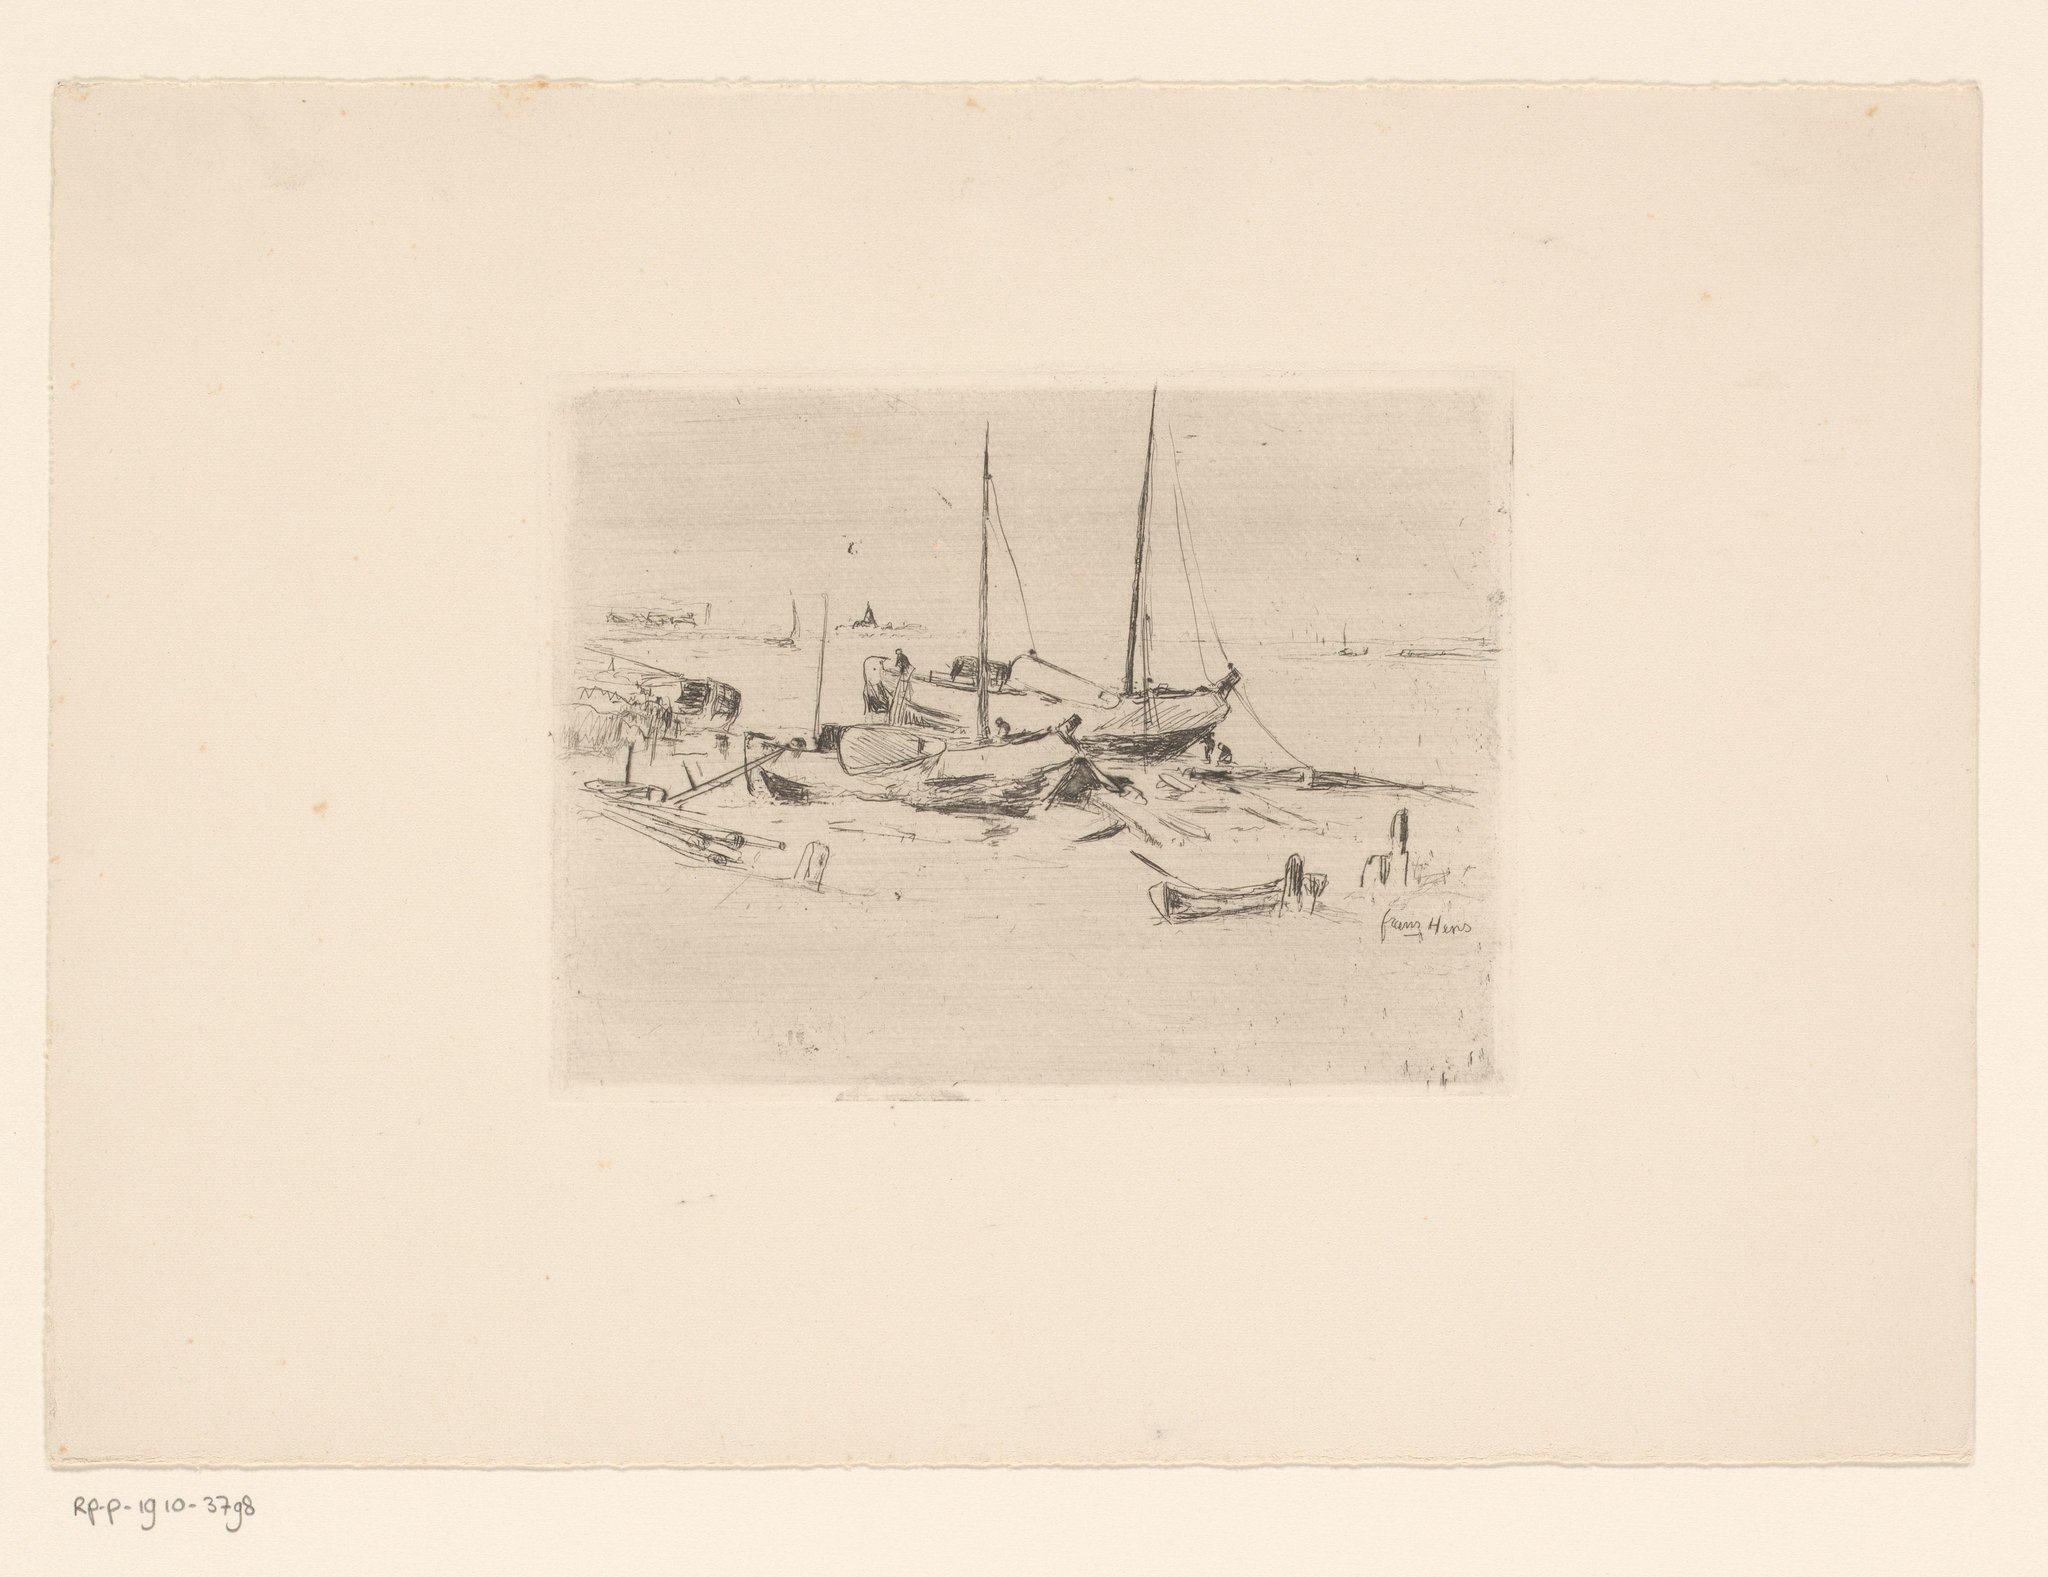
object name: print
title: Twee schepen met zwaarden op het strand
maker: frans hens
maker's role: print maker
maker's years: 1856-1928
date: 1866-1910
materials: paper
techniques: etching, intaglio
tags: ships, boats on land, beached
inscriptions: collector's mark: Lugt 2228